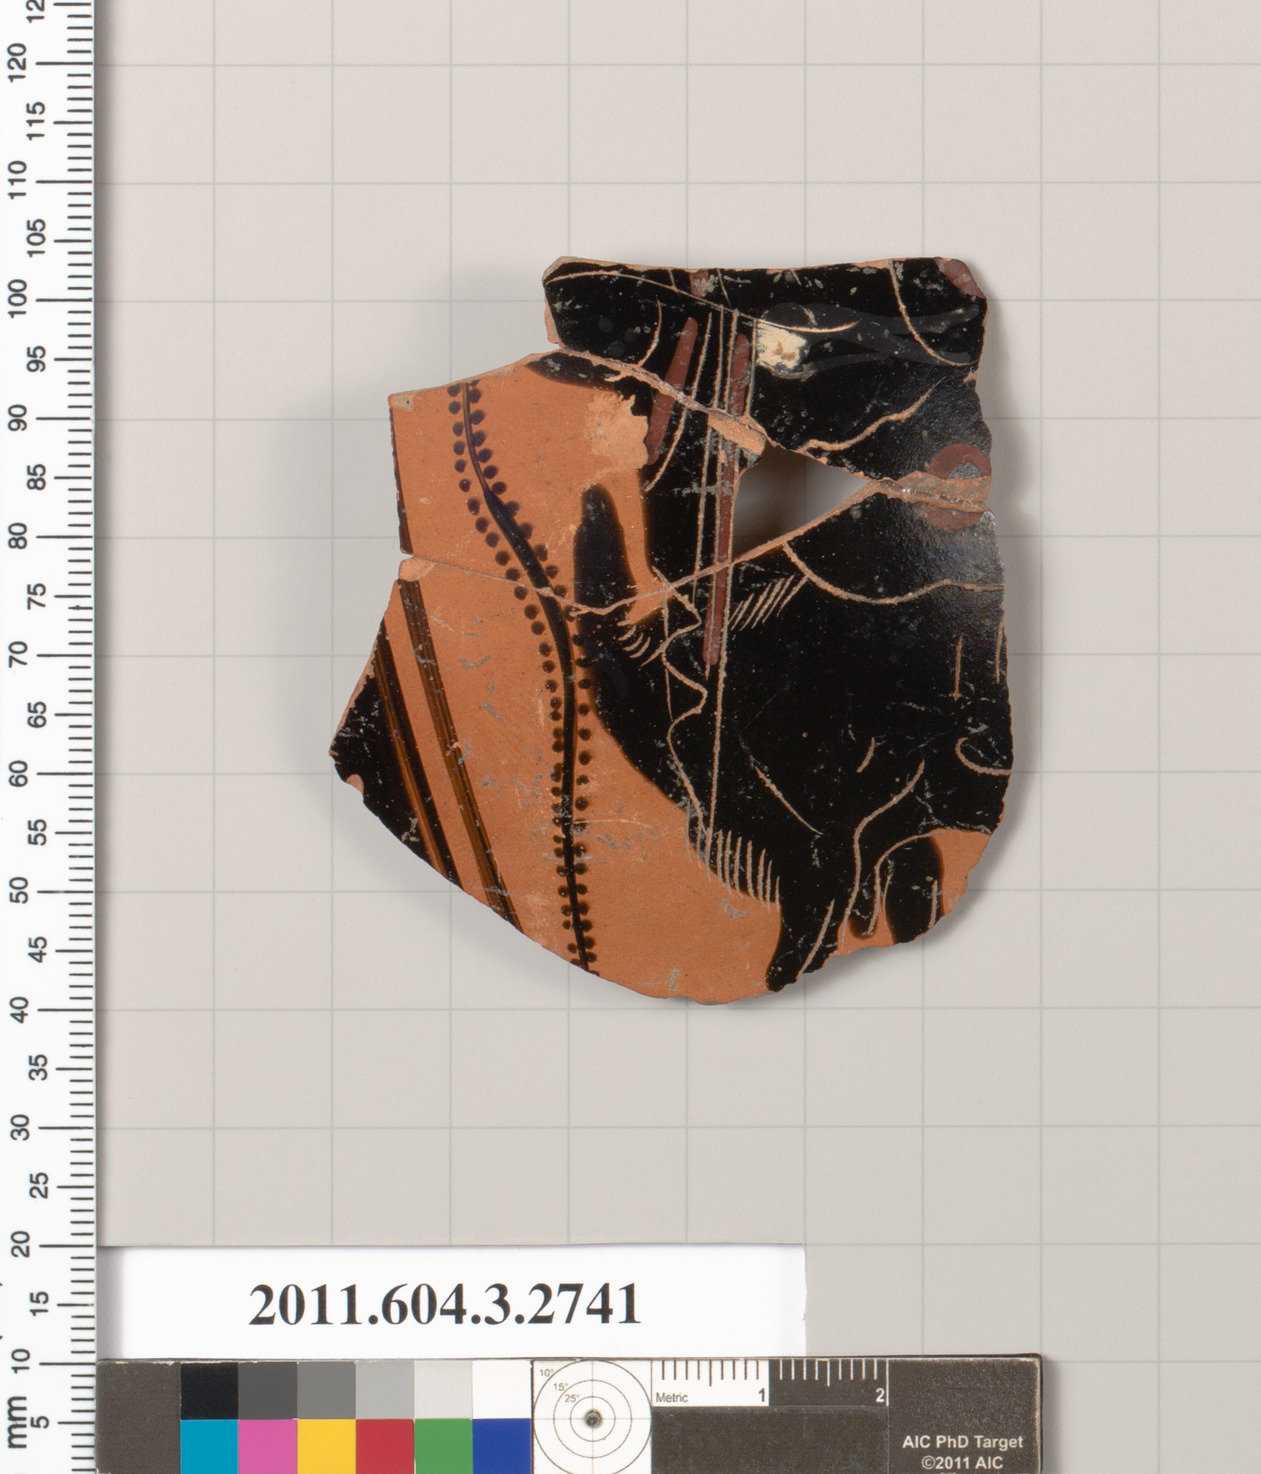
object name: oinochoe or olpe fragment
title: Terracotta fragment of an oinochoe (jug) or olpe (jug)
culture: greek, attic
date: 520-500 BCE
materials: terracotta